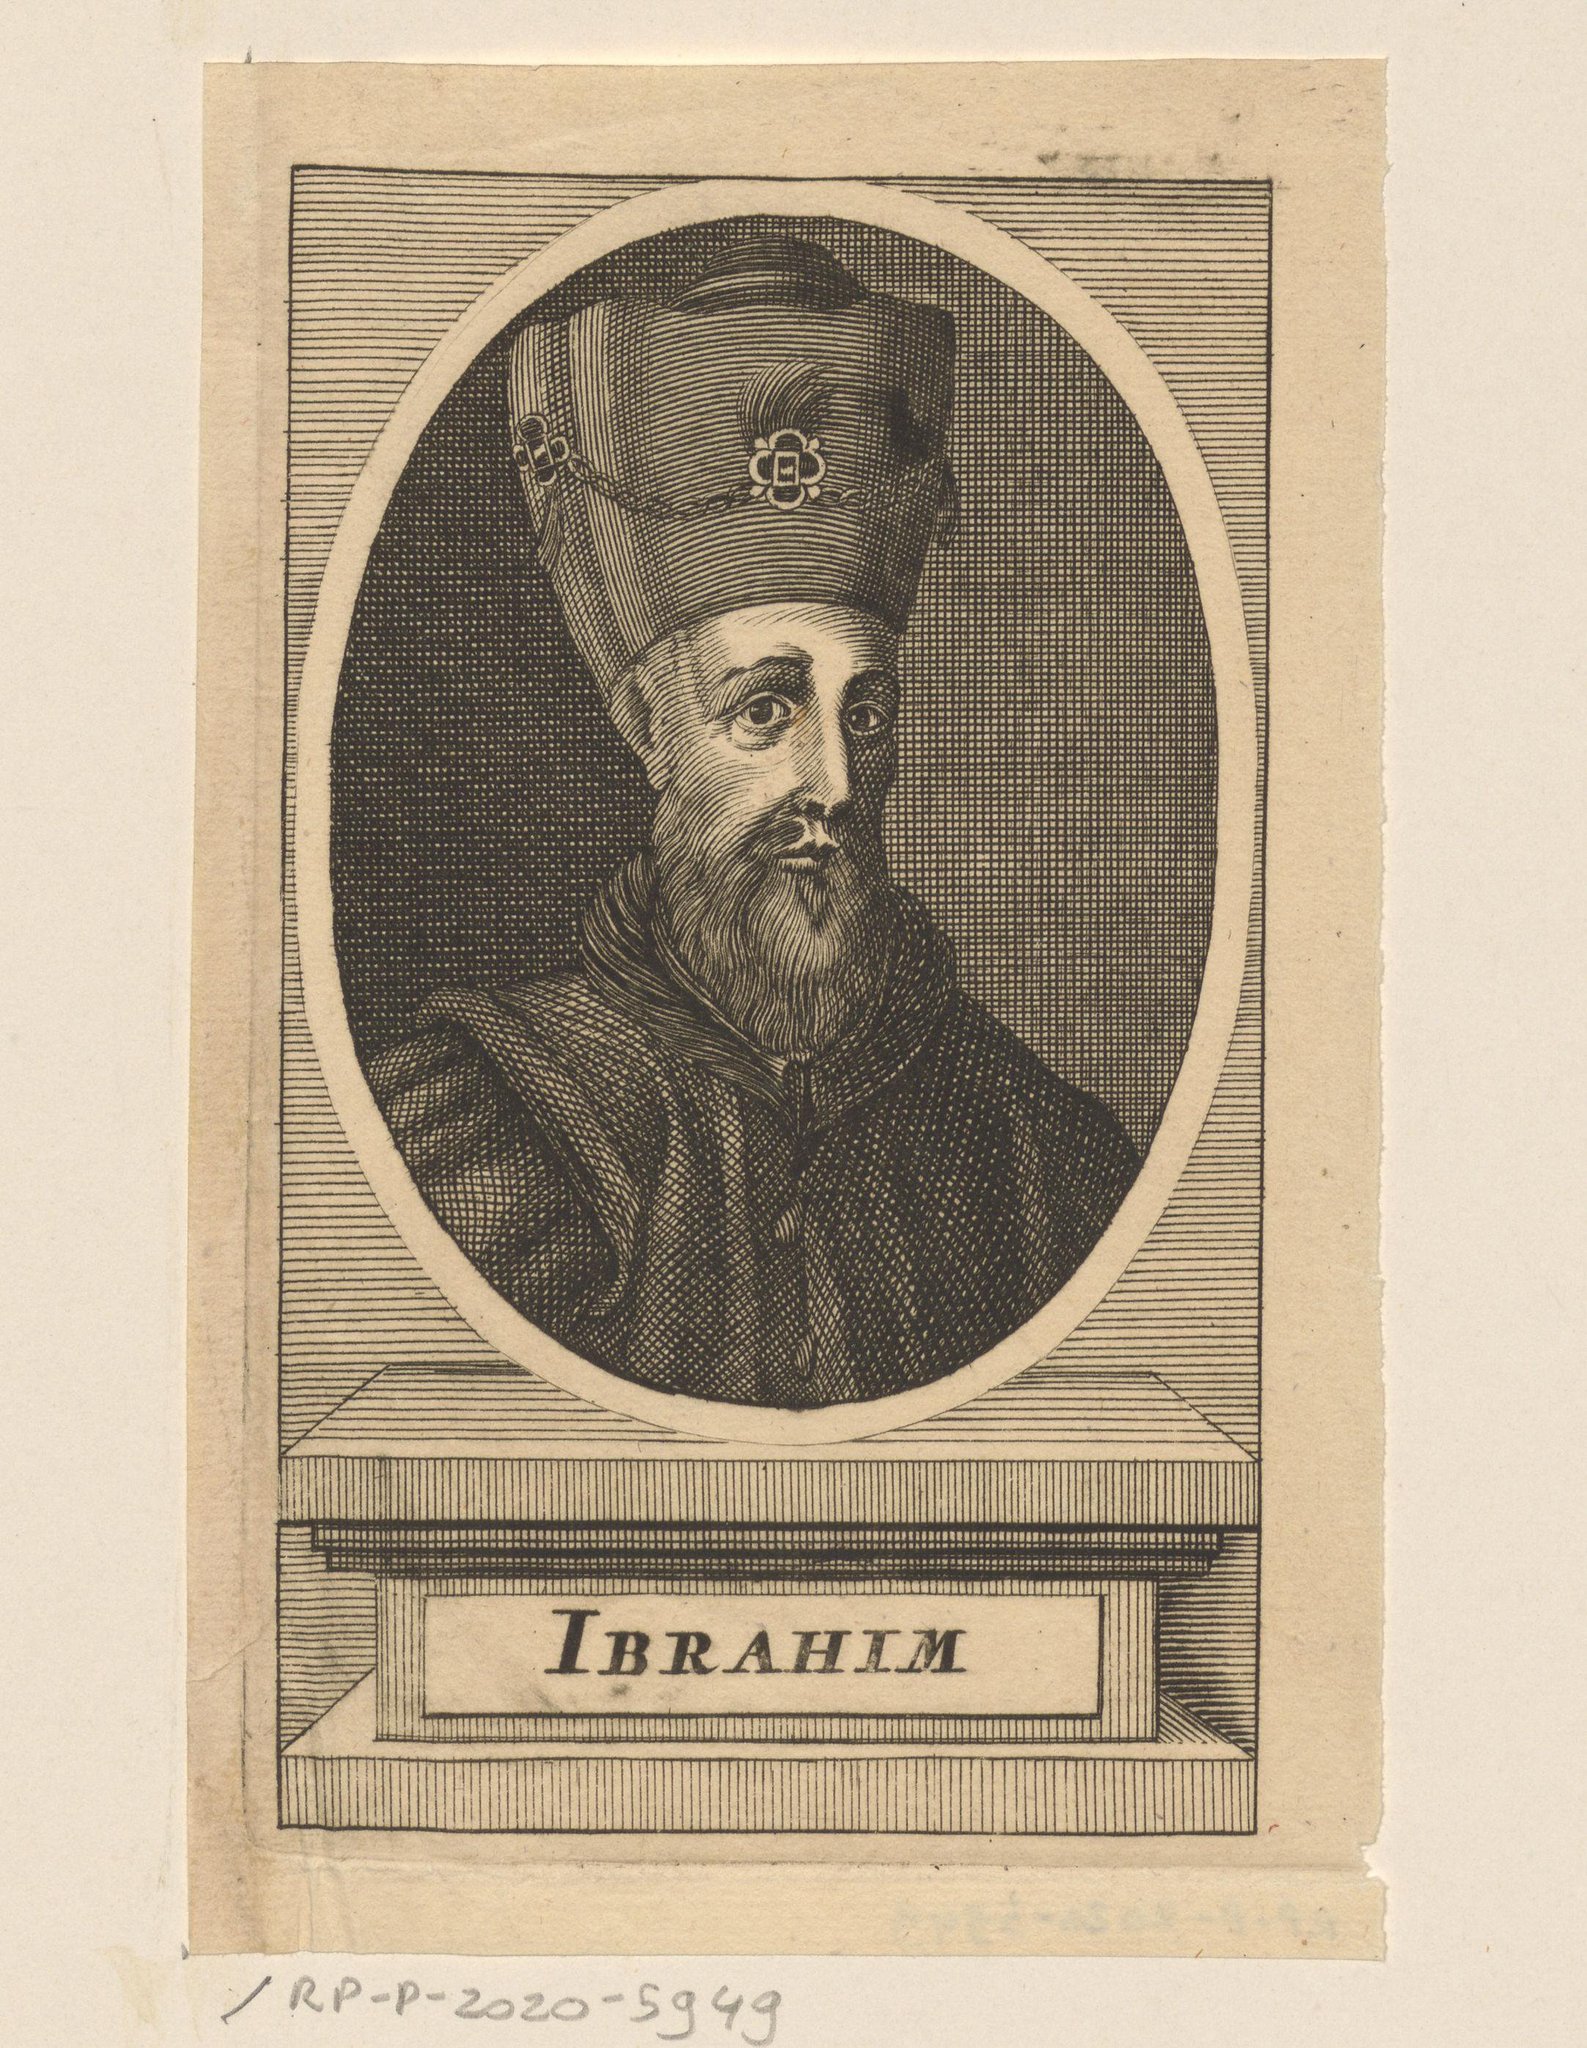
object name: print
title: Portret van Ibrahim I, sultan van Turkije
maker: Anonymous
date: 1697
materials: paper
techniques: engraving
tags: head-gear, historical persons, ruler, sovereign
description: Prent waarschijnlijk uit: Vanel, Claude. Abrege Nouveau de l'Histoire Generale des Turcs (...). Amsterdam: André van Hoogenhuysen, 1697, dl. 3.